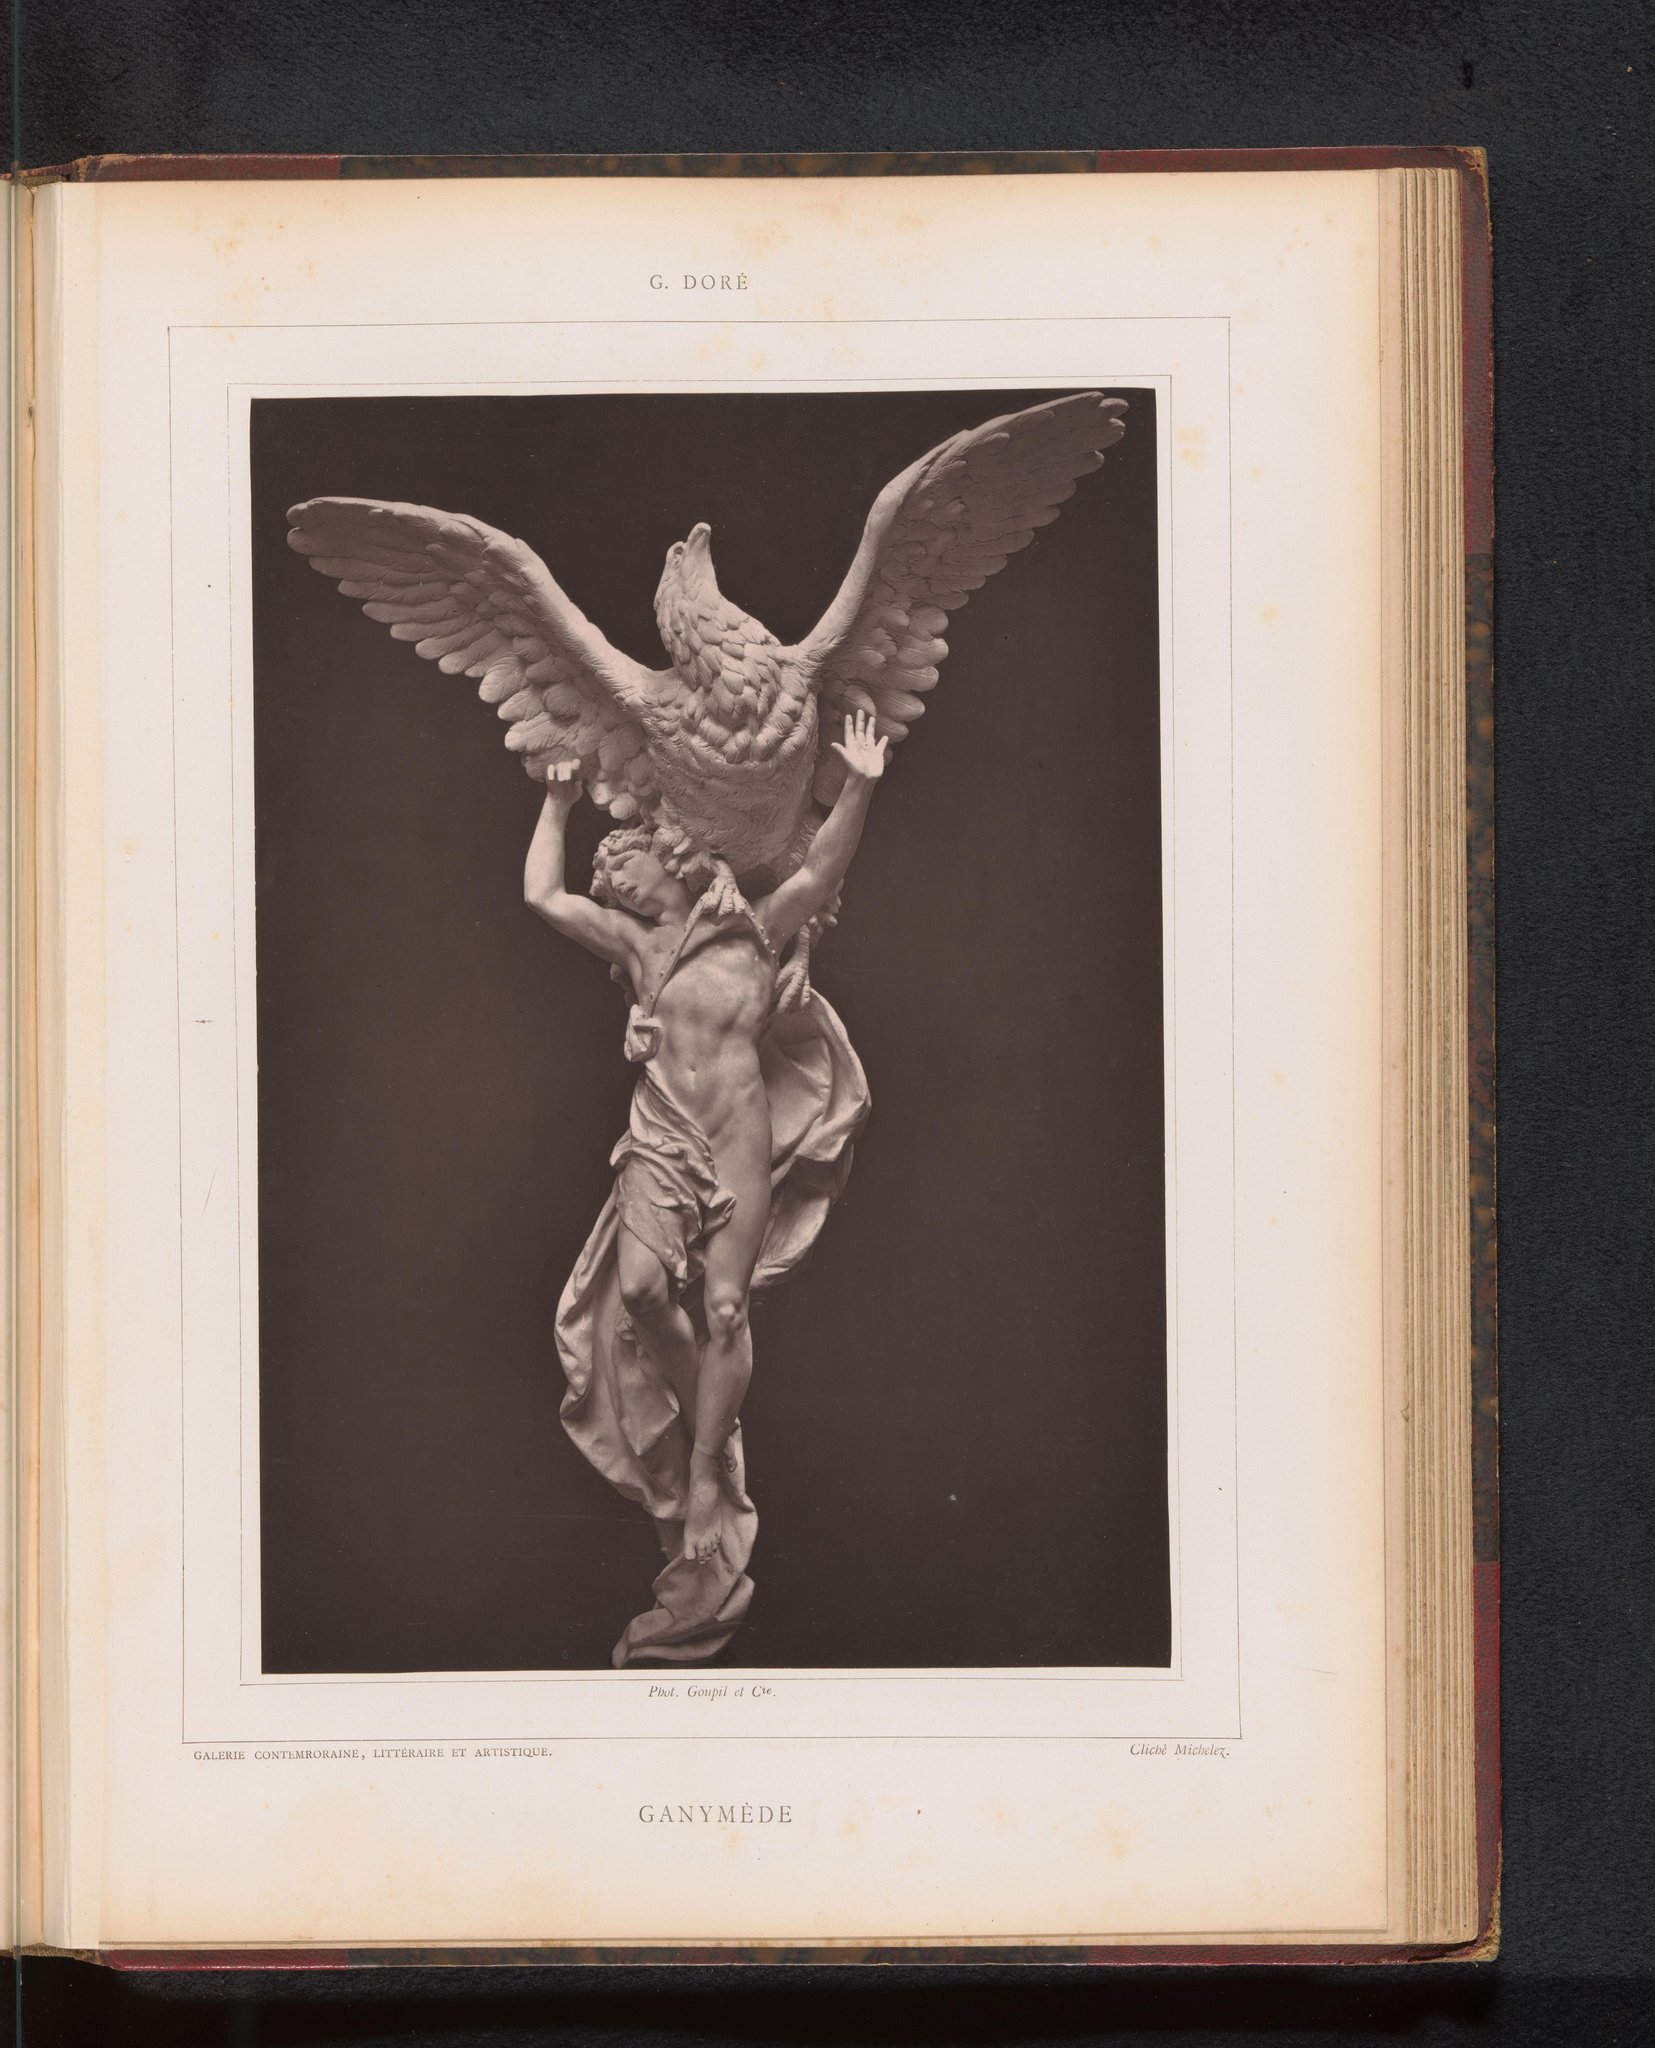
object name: photomechanical print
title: Ganymède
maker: charles michelez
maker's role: fotograaf, fotostudio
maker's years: 1817-1883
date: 1873-1878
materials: paper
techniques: woodburytype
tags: the rape of ganymede: he is carried off through the air by jupiter in the form of an eagle, or by the eagle of jupiter, sculpture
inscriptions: inscription: ‘Galerie Contemporaine, Littéraire et Artistique.’